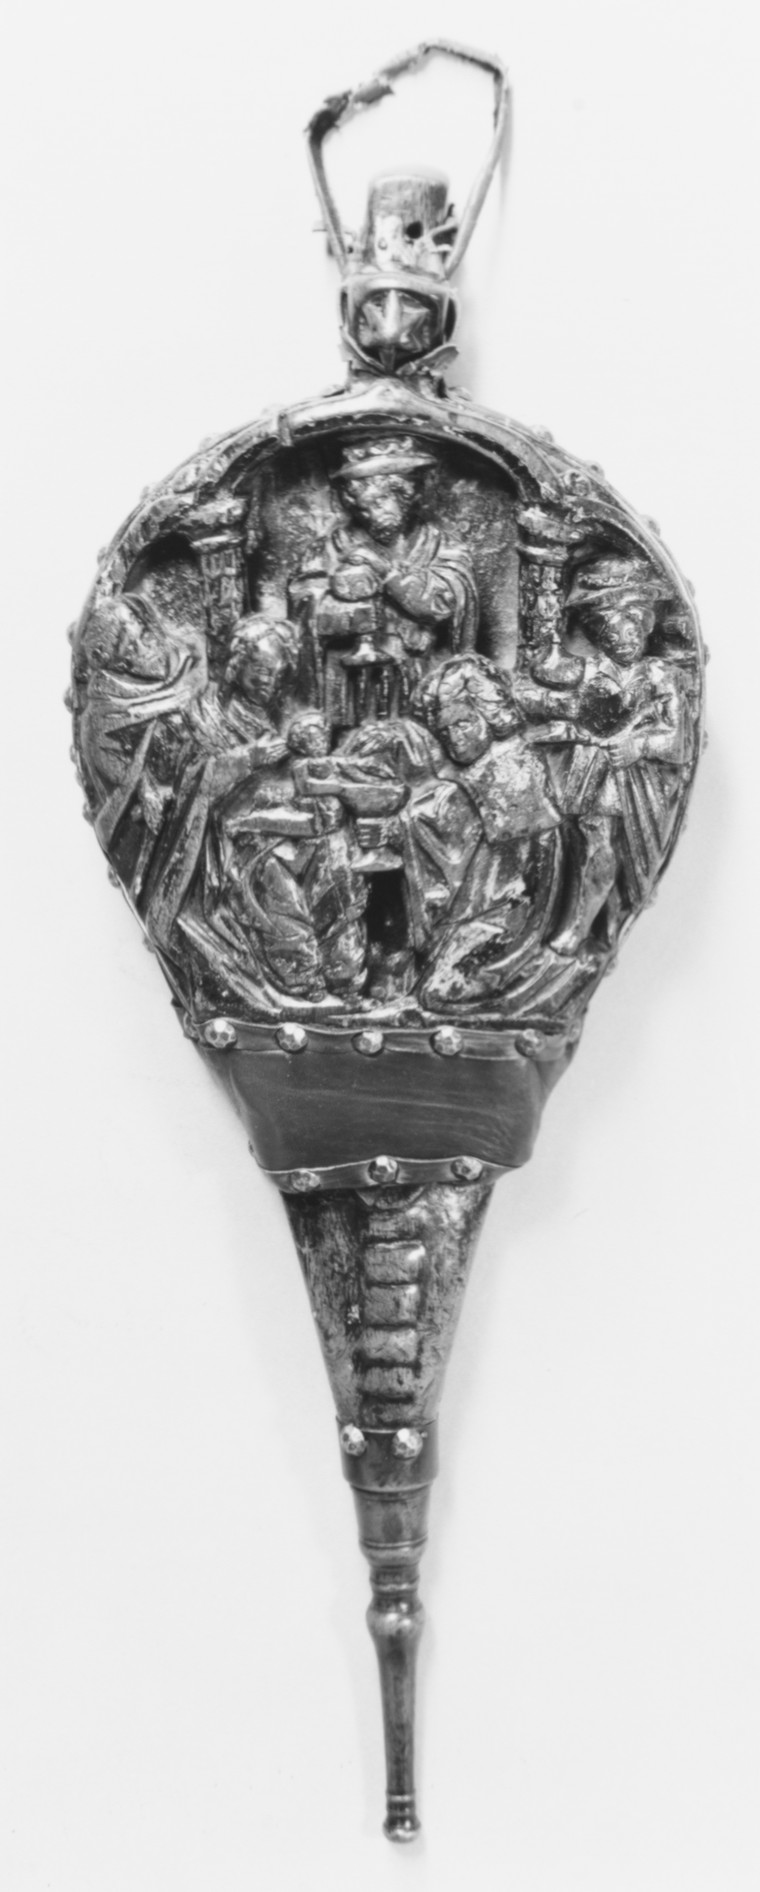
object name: bellow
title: Bellows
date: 1501-1525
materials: wood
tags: nativity